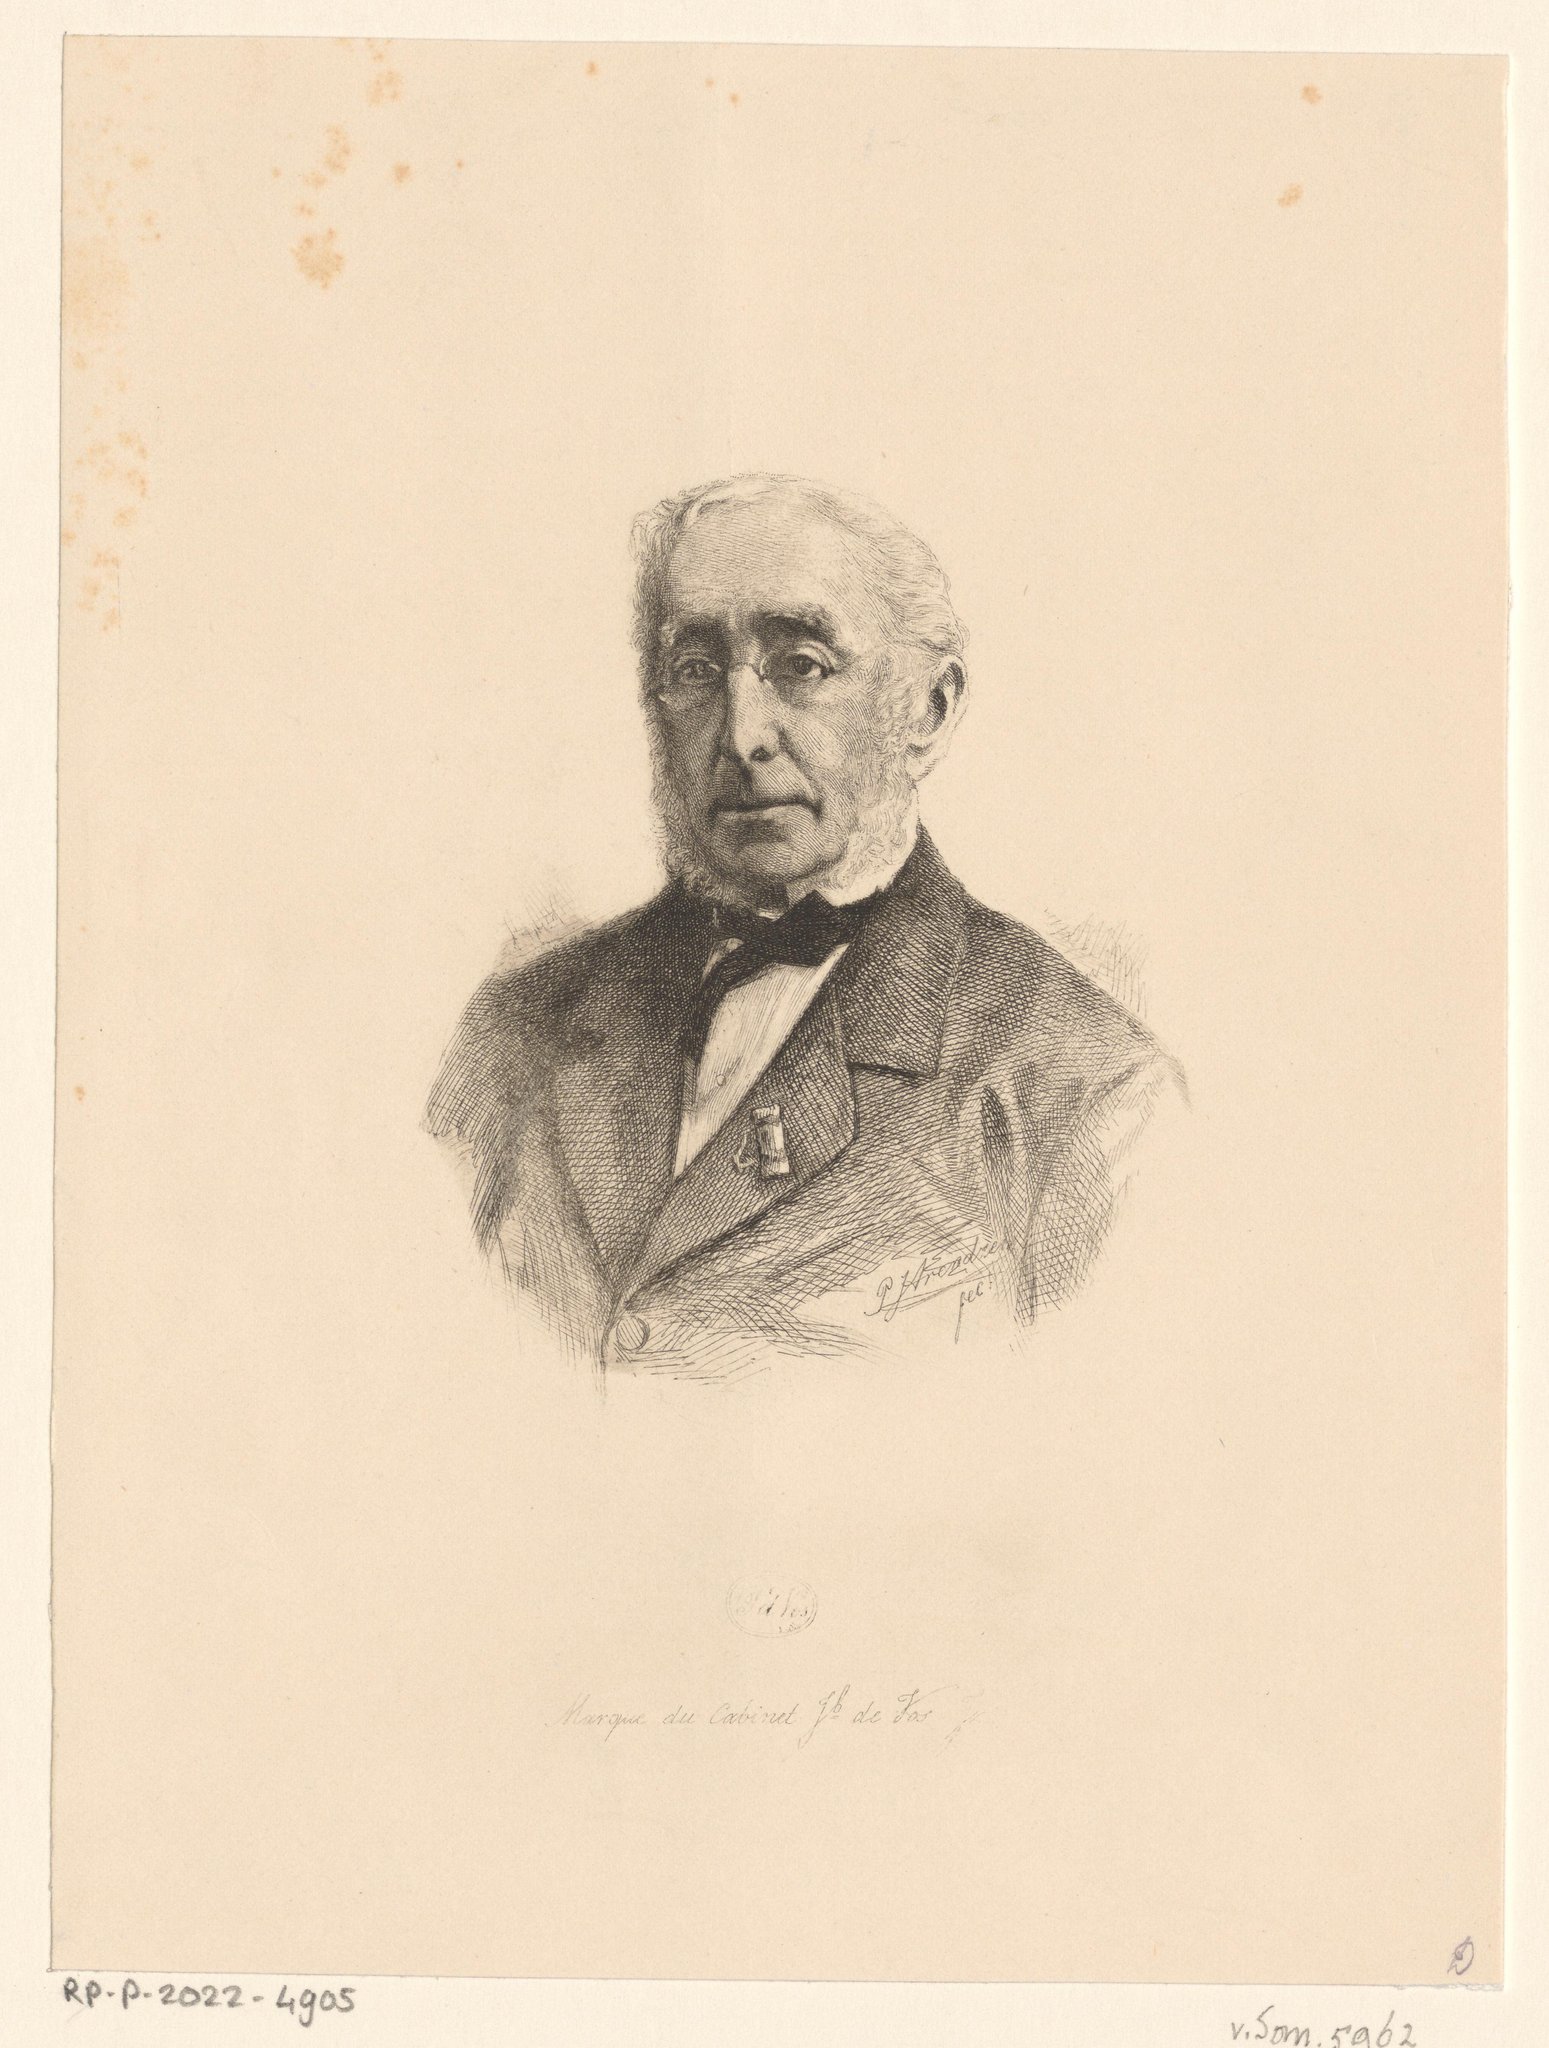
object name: print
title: Portret van Jacob Jacobsz. de Vos.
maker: petrus johannes arendzen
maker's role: draughtsman, print maker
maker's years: 1846-1932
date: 1856-1878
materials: paper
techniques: etching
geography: netherlands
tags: amsterdam, haarlem, jacob jacobsz. de vos (1803-1878), historical persons, art collector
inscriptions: collector's mark: Lugt 1450